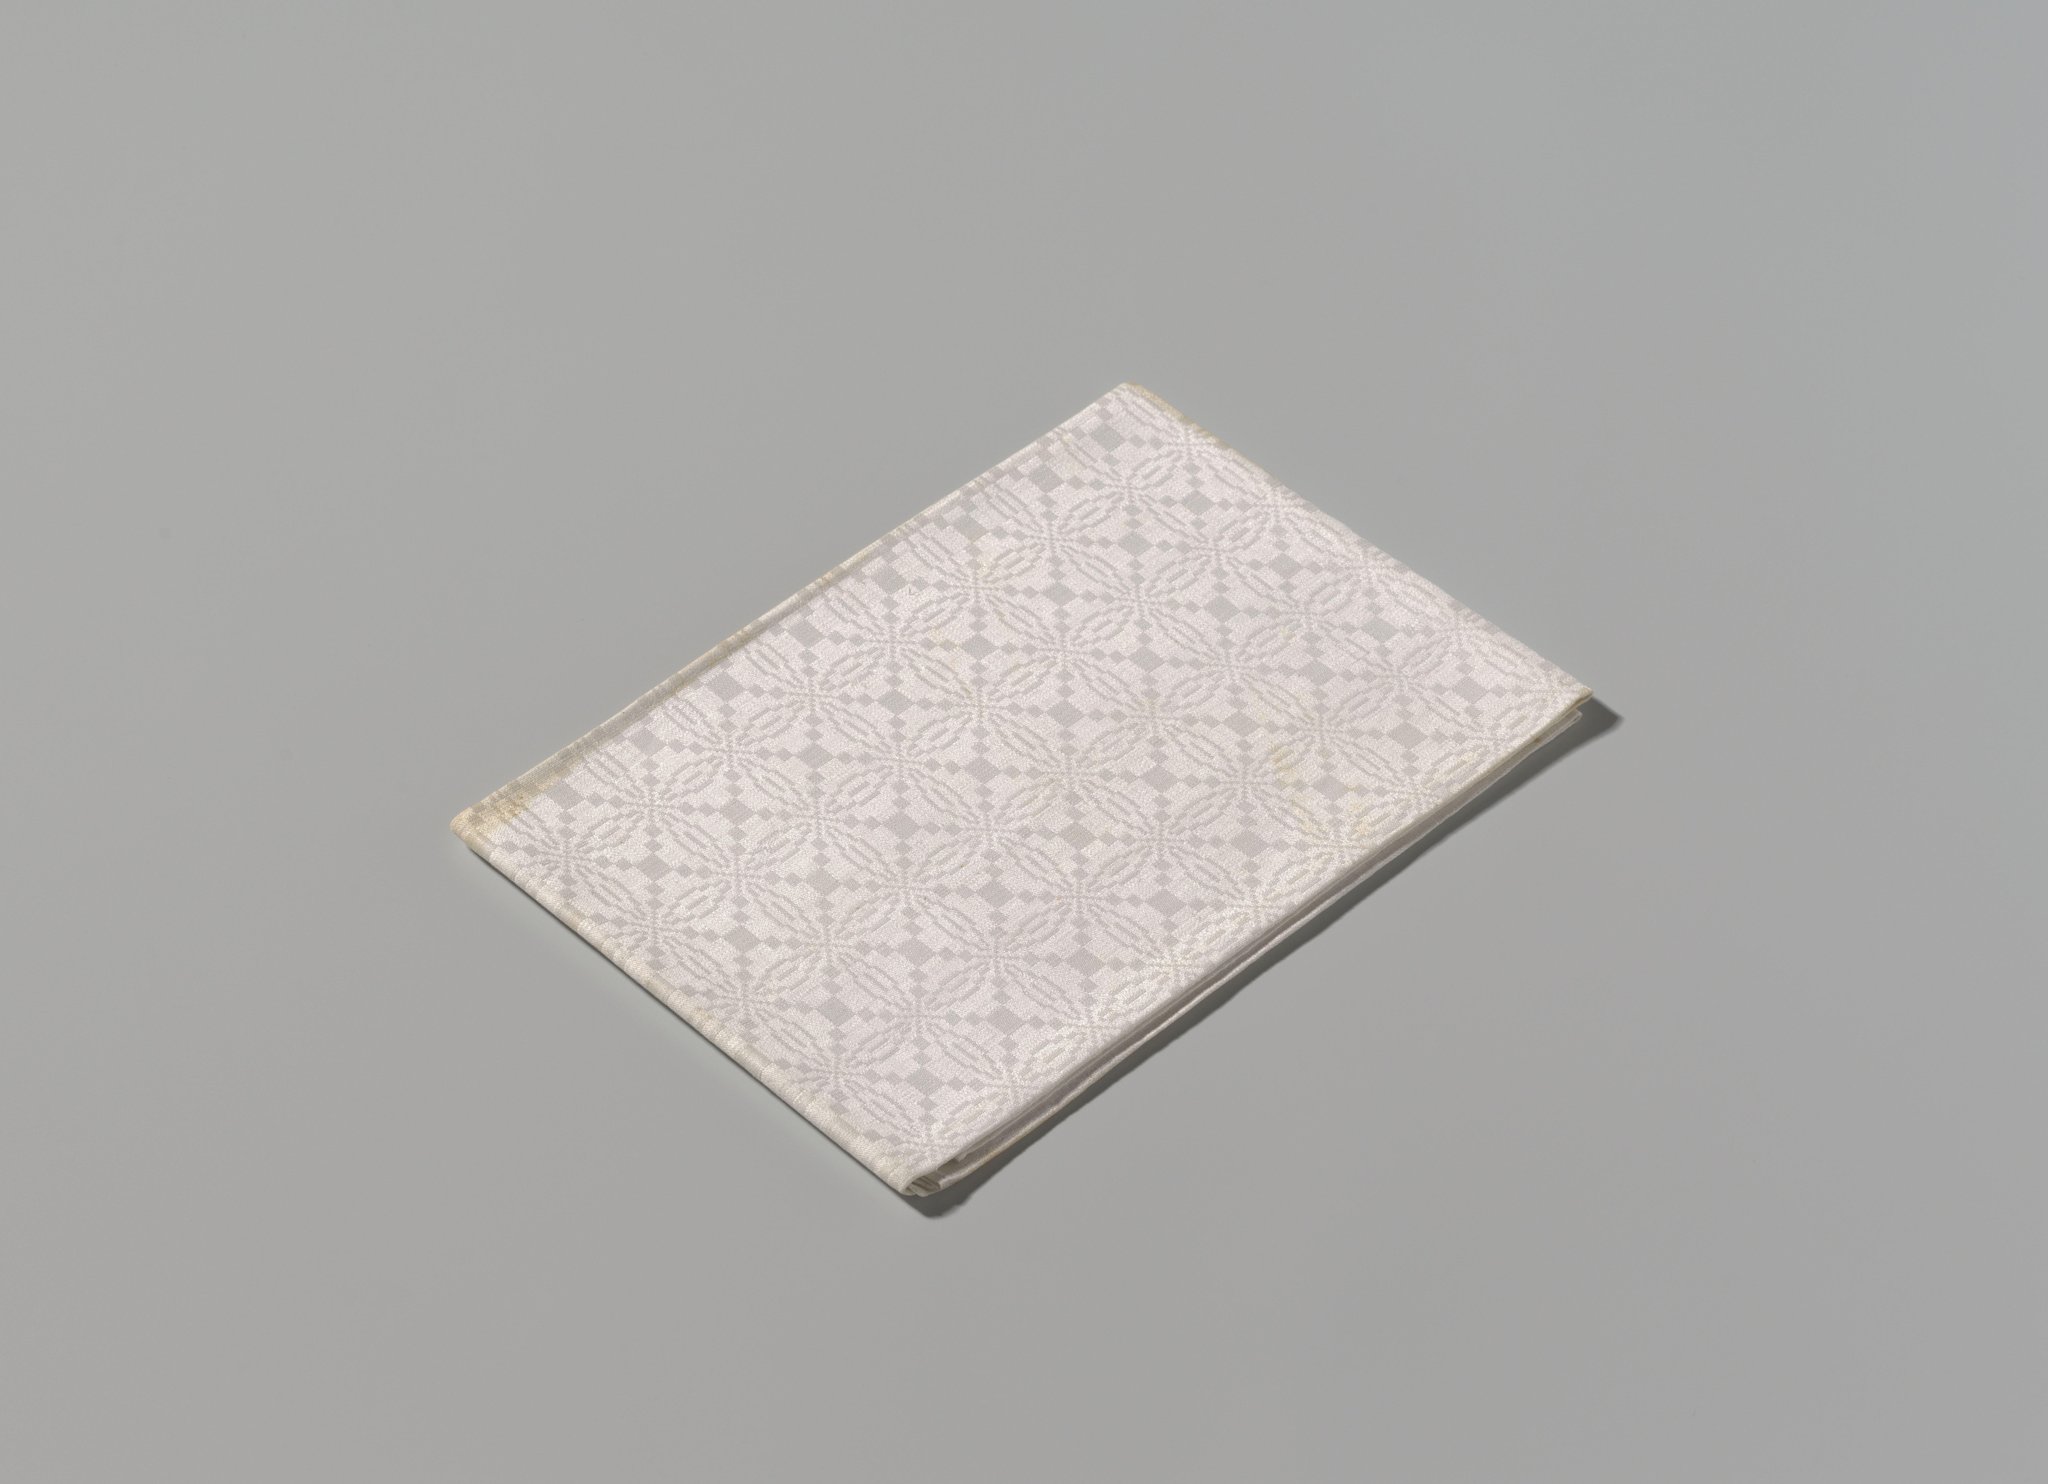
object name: napkin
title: Servet van linnen met pellenpatroon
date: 1600-1650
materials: linen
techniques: peeled fabric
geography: northern netherlands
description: wit linnen servet met pellen patroon, merk HB 26